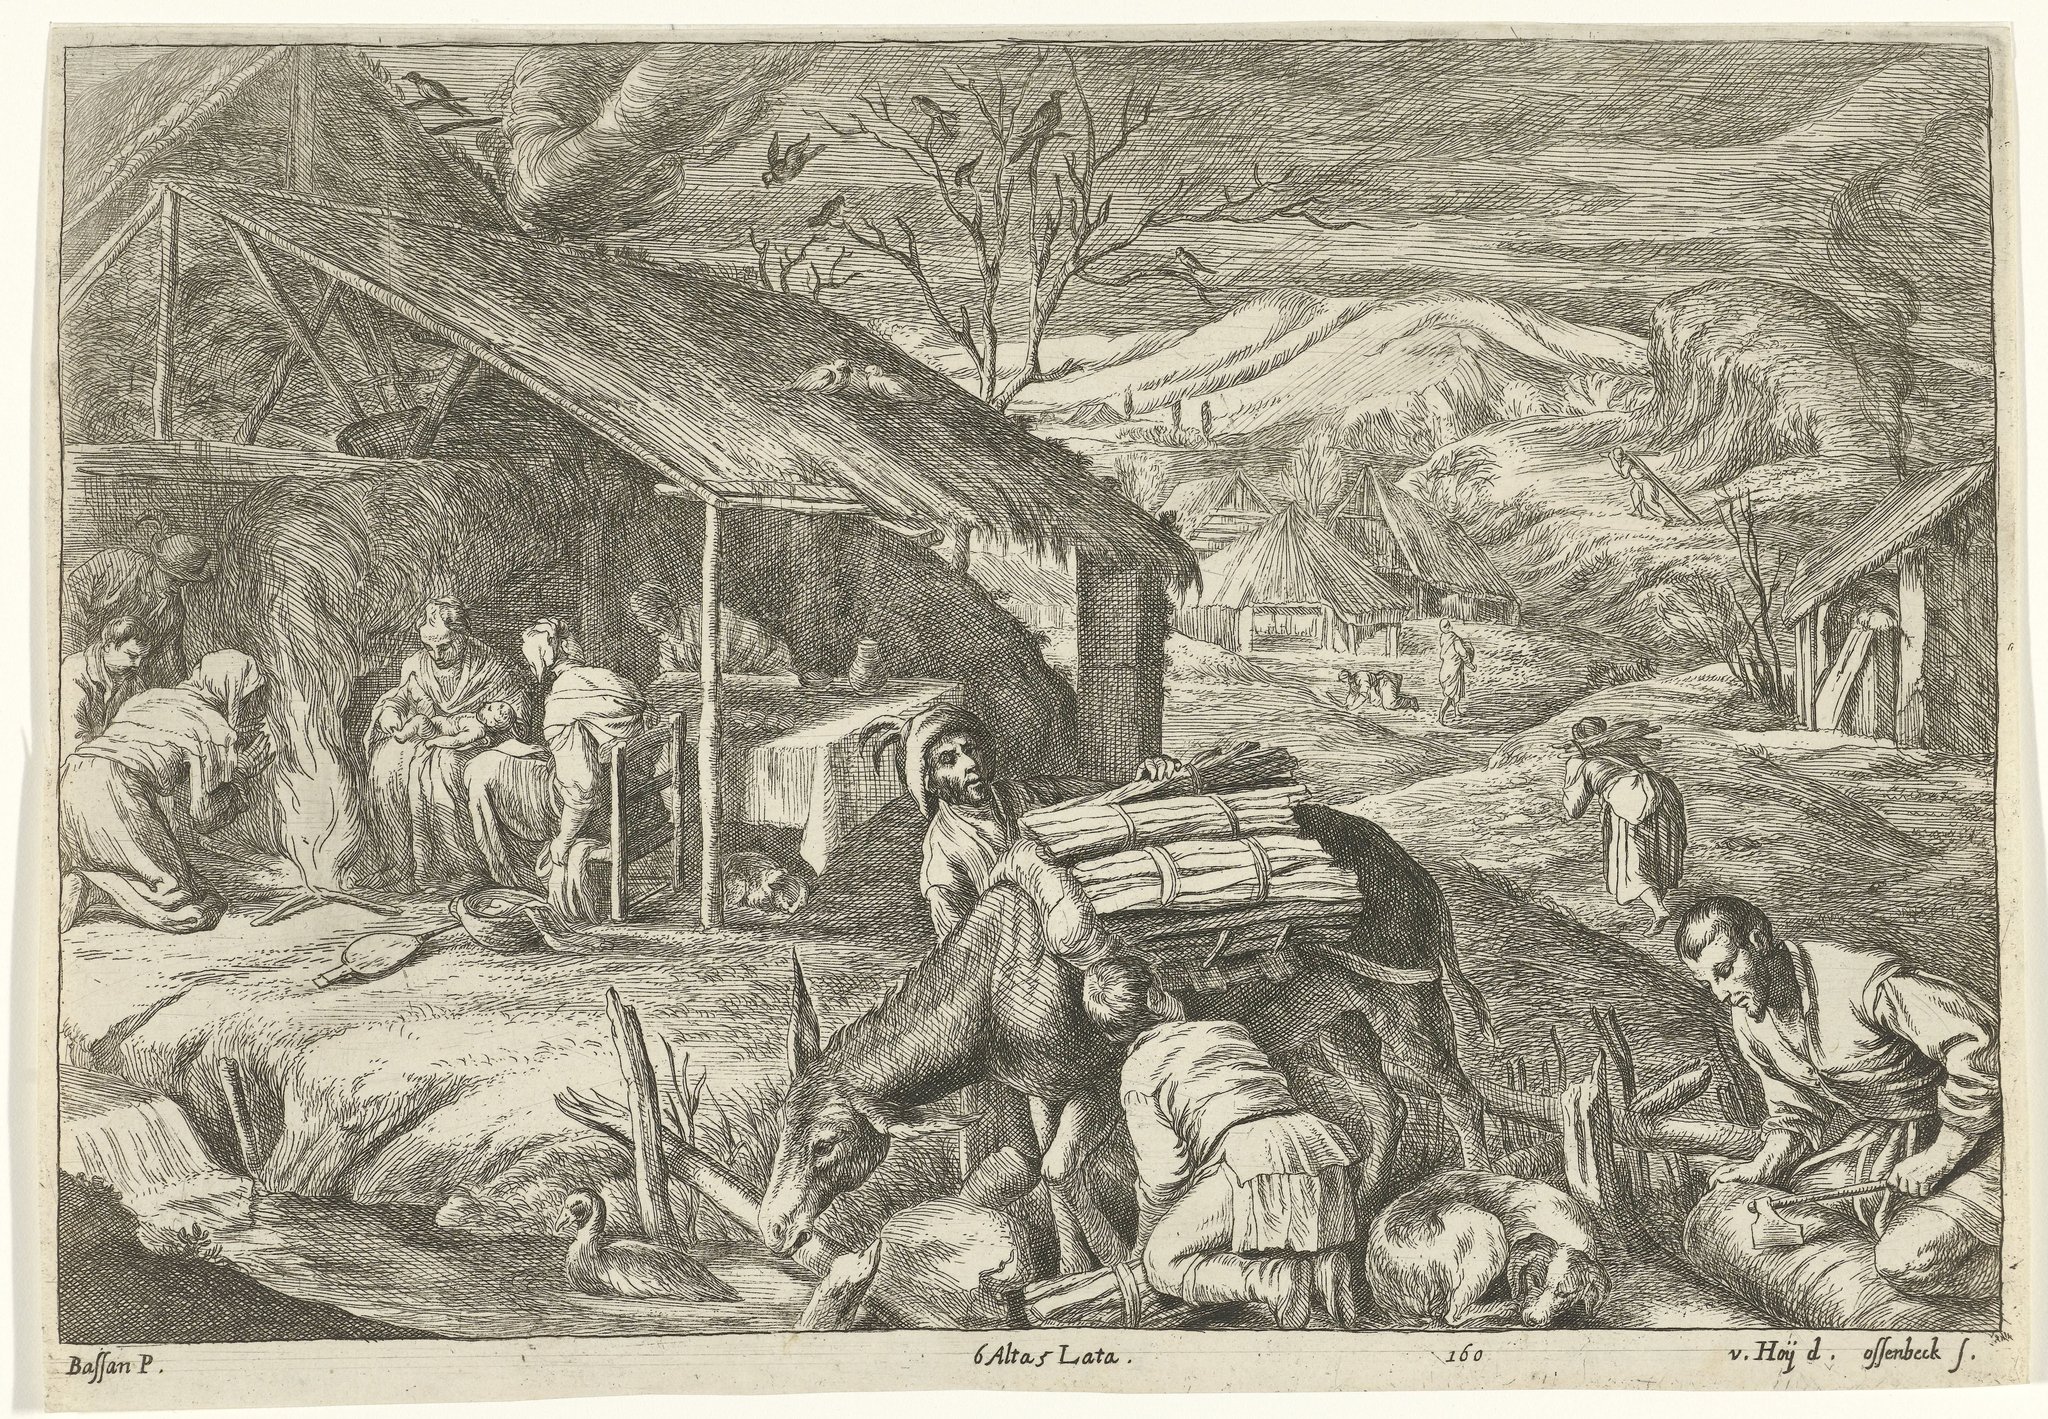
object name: print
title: Winter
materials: paper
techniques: engraving, etching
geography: brussels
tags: woodgathering, woodgatherer, winter landscape; landscape symbolizing winter (the four seasons of the year)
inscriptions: collector's mark: Lugt 2228, collector's mark: Lugt 1407, collector's mark: Lugt 2610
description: Twee mannen beladen een ezel met hout. Een derde man hakt een boomstam in stukjes. Links een gezin dat rond een vuur zit in hun hut en schuilt voor de winterkou. Rechts drie figuren die hout sprokkelen. Voorstelling van de winter uit een prentserie van de vier seizoenen.